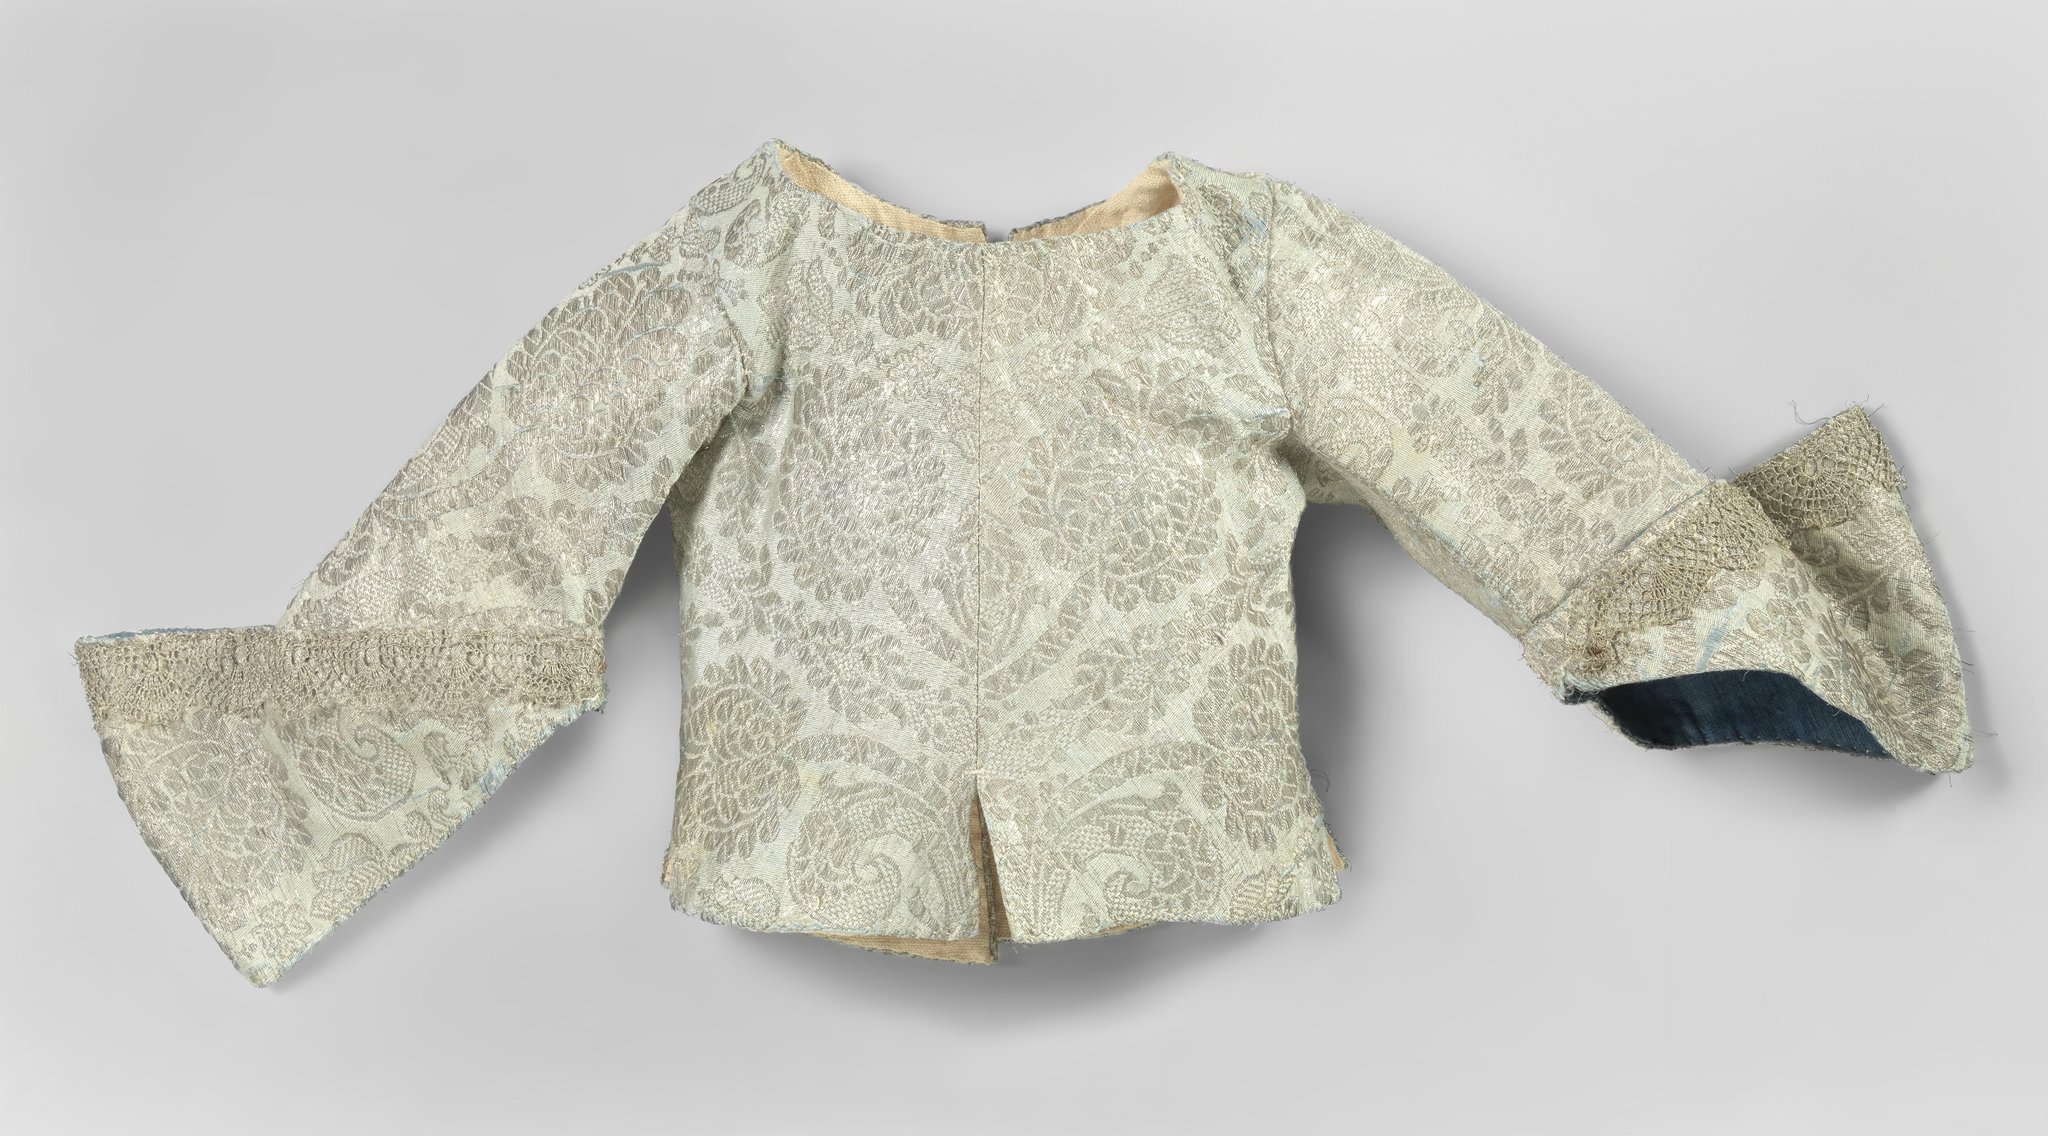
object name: childrenswear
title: Jas van zijden brokaat, zilver op een lichtblauw fond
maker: Anonymous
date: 1650-1700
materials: linen, silk, thread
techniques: lace, weave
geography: france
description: Een kinderjasje van zijden brokaat, in zilver op lichtblauw. Model: het korte, recht afgesneden voorpand van schuin geknipte brokaat heeft een wijde hals, één middennaad en splitjes middenvoor en opzij. De sluiting geschiedt in de rug met een koordje en een rij grove nestelgaatjes, die bij de taille ophoudt. De rugpanden zijn hol gesneden voor een uitstaand, kort schootje, dat aan de onderzijde flauw rond is geknipt. Zeer wijde, gladde mouwjes zijn met een taps toelopende manchet versierd. Langs de manchetten een strook gekloste zilverkant. Materiaal: lampas(?) met zilverdraad gelanceerd. Een lichtblauwe zijden grond van kettingkeper (3:1) is met zilverlamé gelanceerd (voor 9/10 verdwenen). Er is een dunne flets lichtblauwe ketting en een dikke, iets krachtiger blauwe bindinslag. Op de lichtblauwe achtergrond staat, en creux, een gelanceerd patroon van zilver (zijden kern). Deze zilverdraad is flottant en slechts hier en daar met de ketting gebonden, onregelmatig of in cannetillé. Patroon: uit een grote arabestk, met een voluut beginnend en door een blad oversneden, ontspringt een gebogen tak met grote granaatappel. Dit wordt symmetrisch herhaald ter zijden van een stam met rasterwerk, oversneden door een bladknop en een rozet. Dit middelgrote decor vertoont een tweede smal kandelabermotief, een variant van dat op de middenas. Voering: licht oranje grof linnen; de manchetten zijn gevoerd met korenblauw linnen.